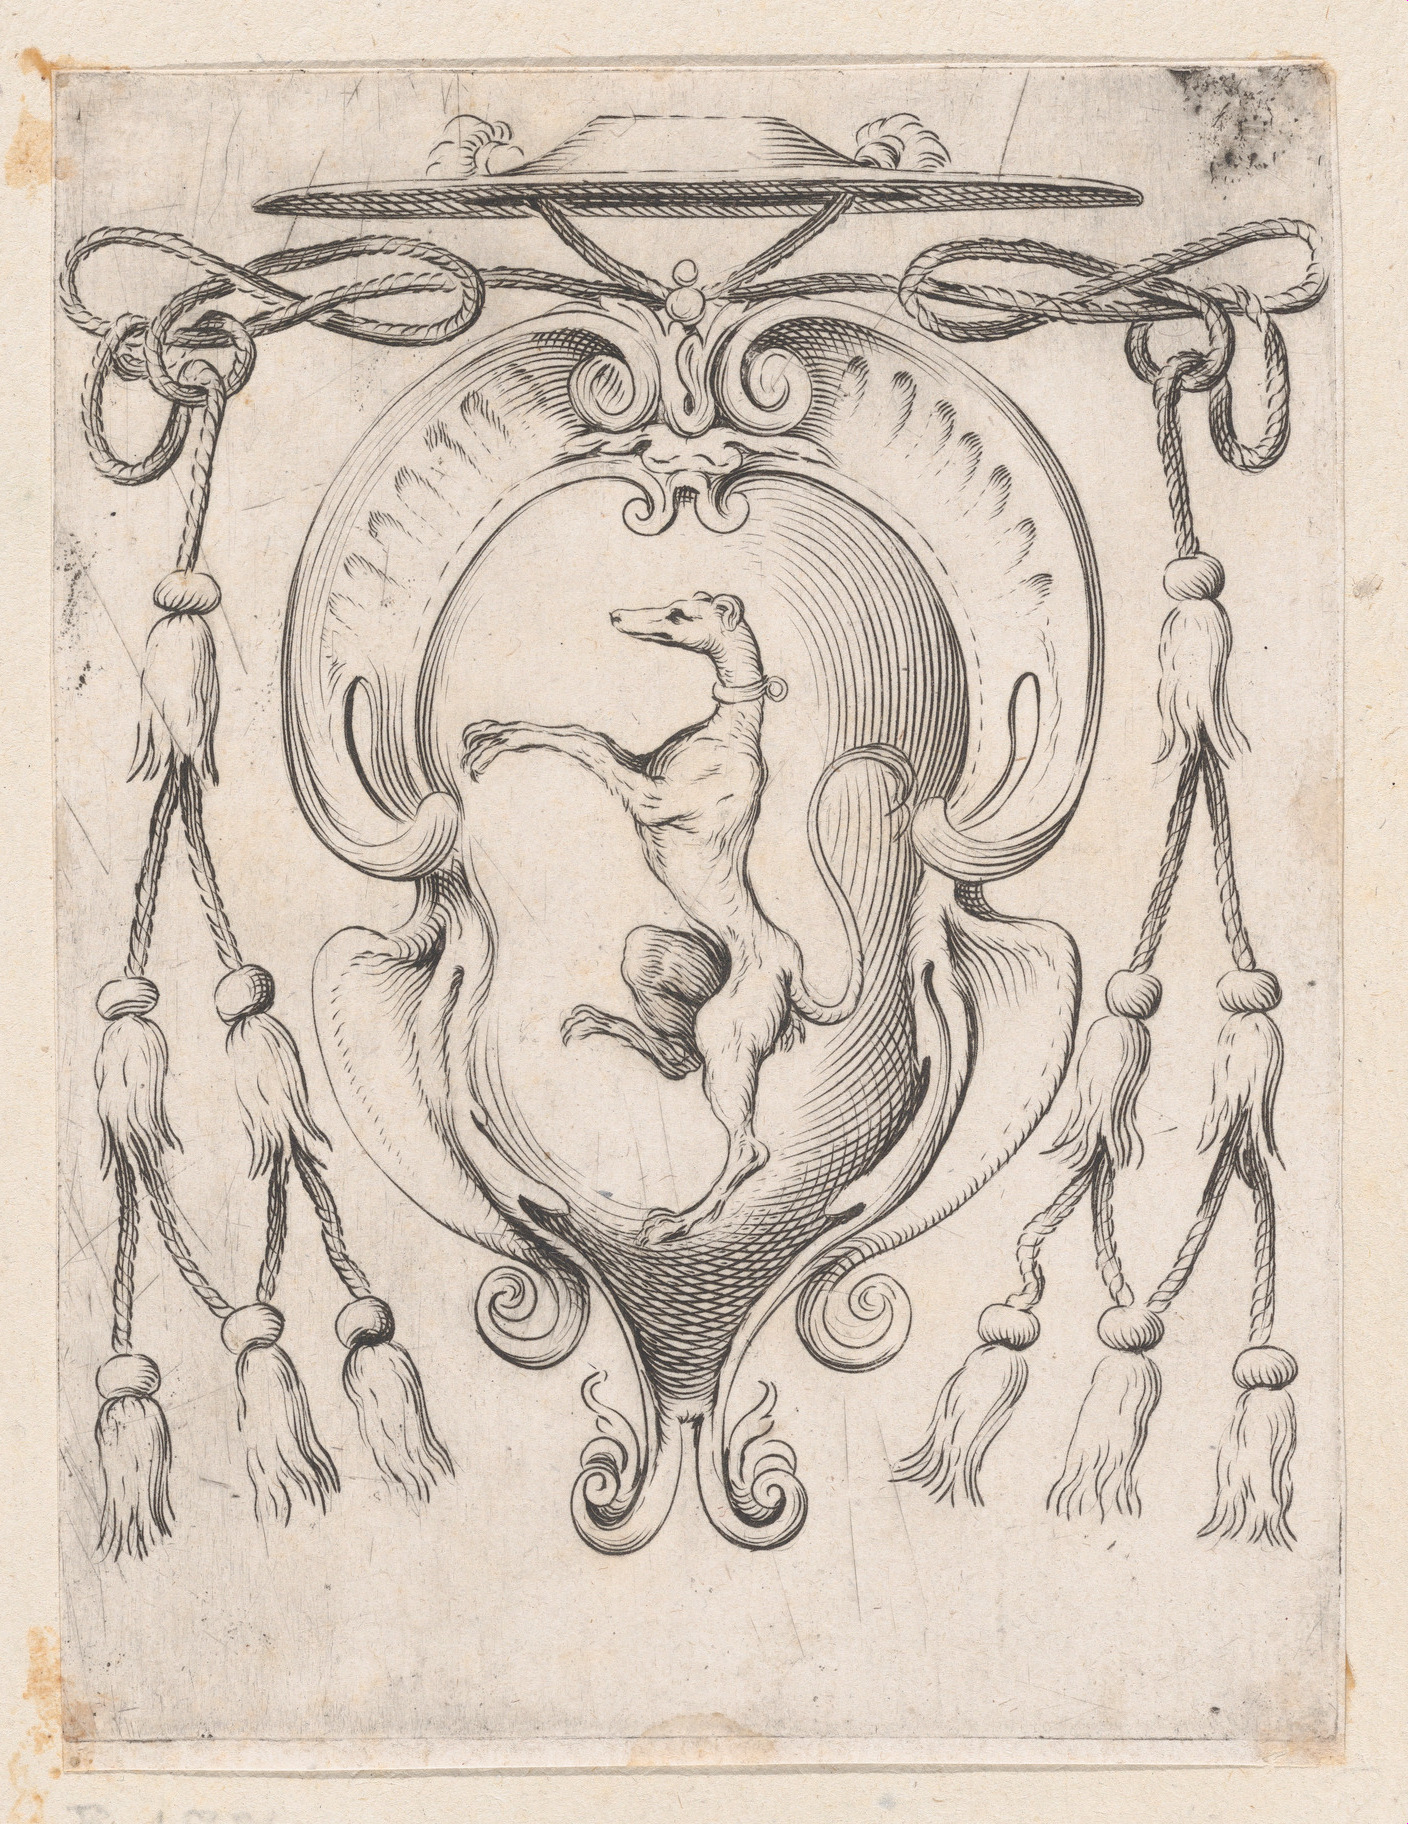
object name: print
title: Coat of Arms of a Cardinal of the Sampieri Family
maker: agostino carracci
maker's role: artist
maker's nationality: italian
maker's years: 1557-1602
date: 1590-1595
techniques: engraving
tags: dogs,coat of arms